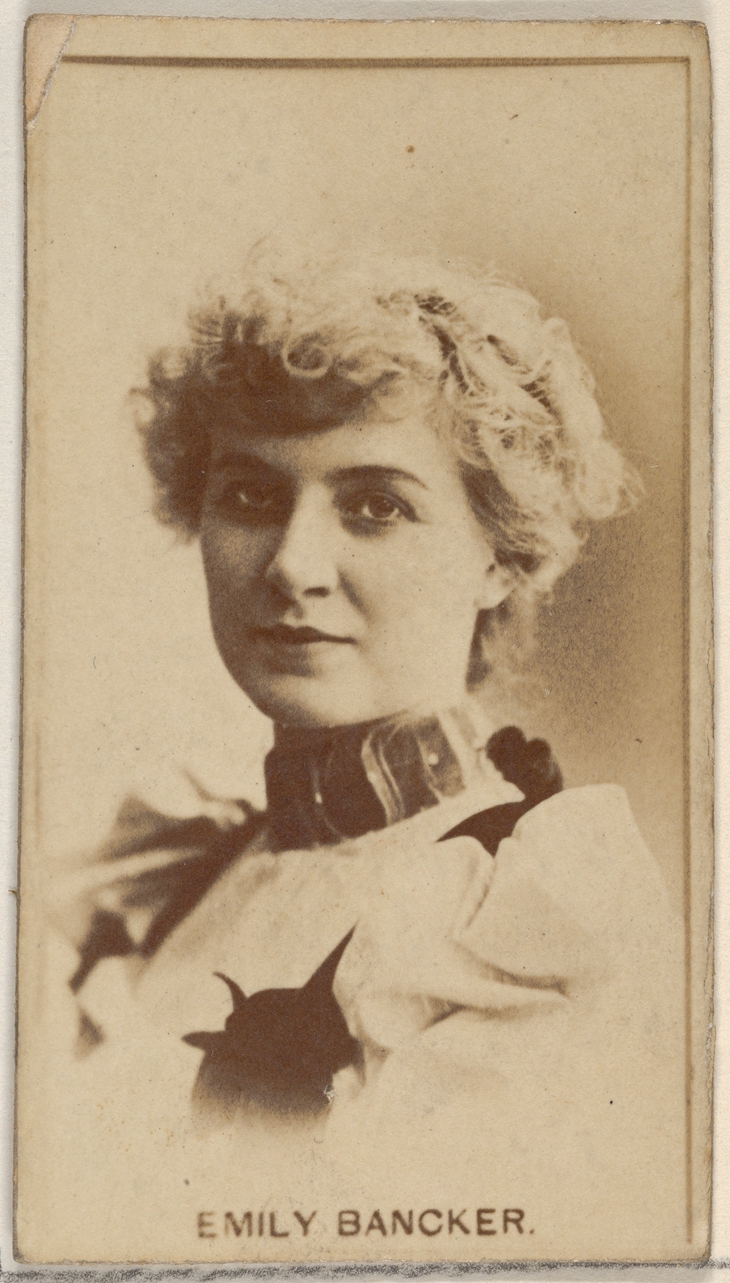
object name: photograph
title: Emily Bancker, from the Actors and Actresses series (N45, Type 8) for Virginia Brights Cigarettes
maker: allen & ginter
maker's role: publisher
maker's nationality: american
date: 1888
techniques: albumen silver print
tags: portraits,women,actresses